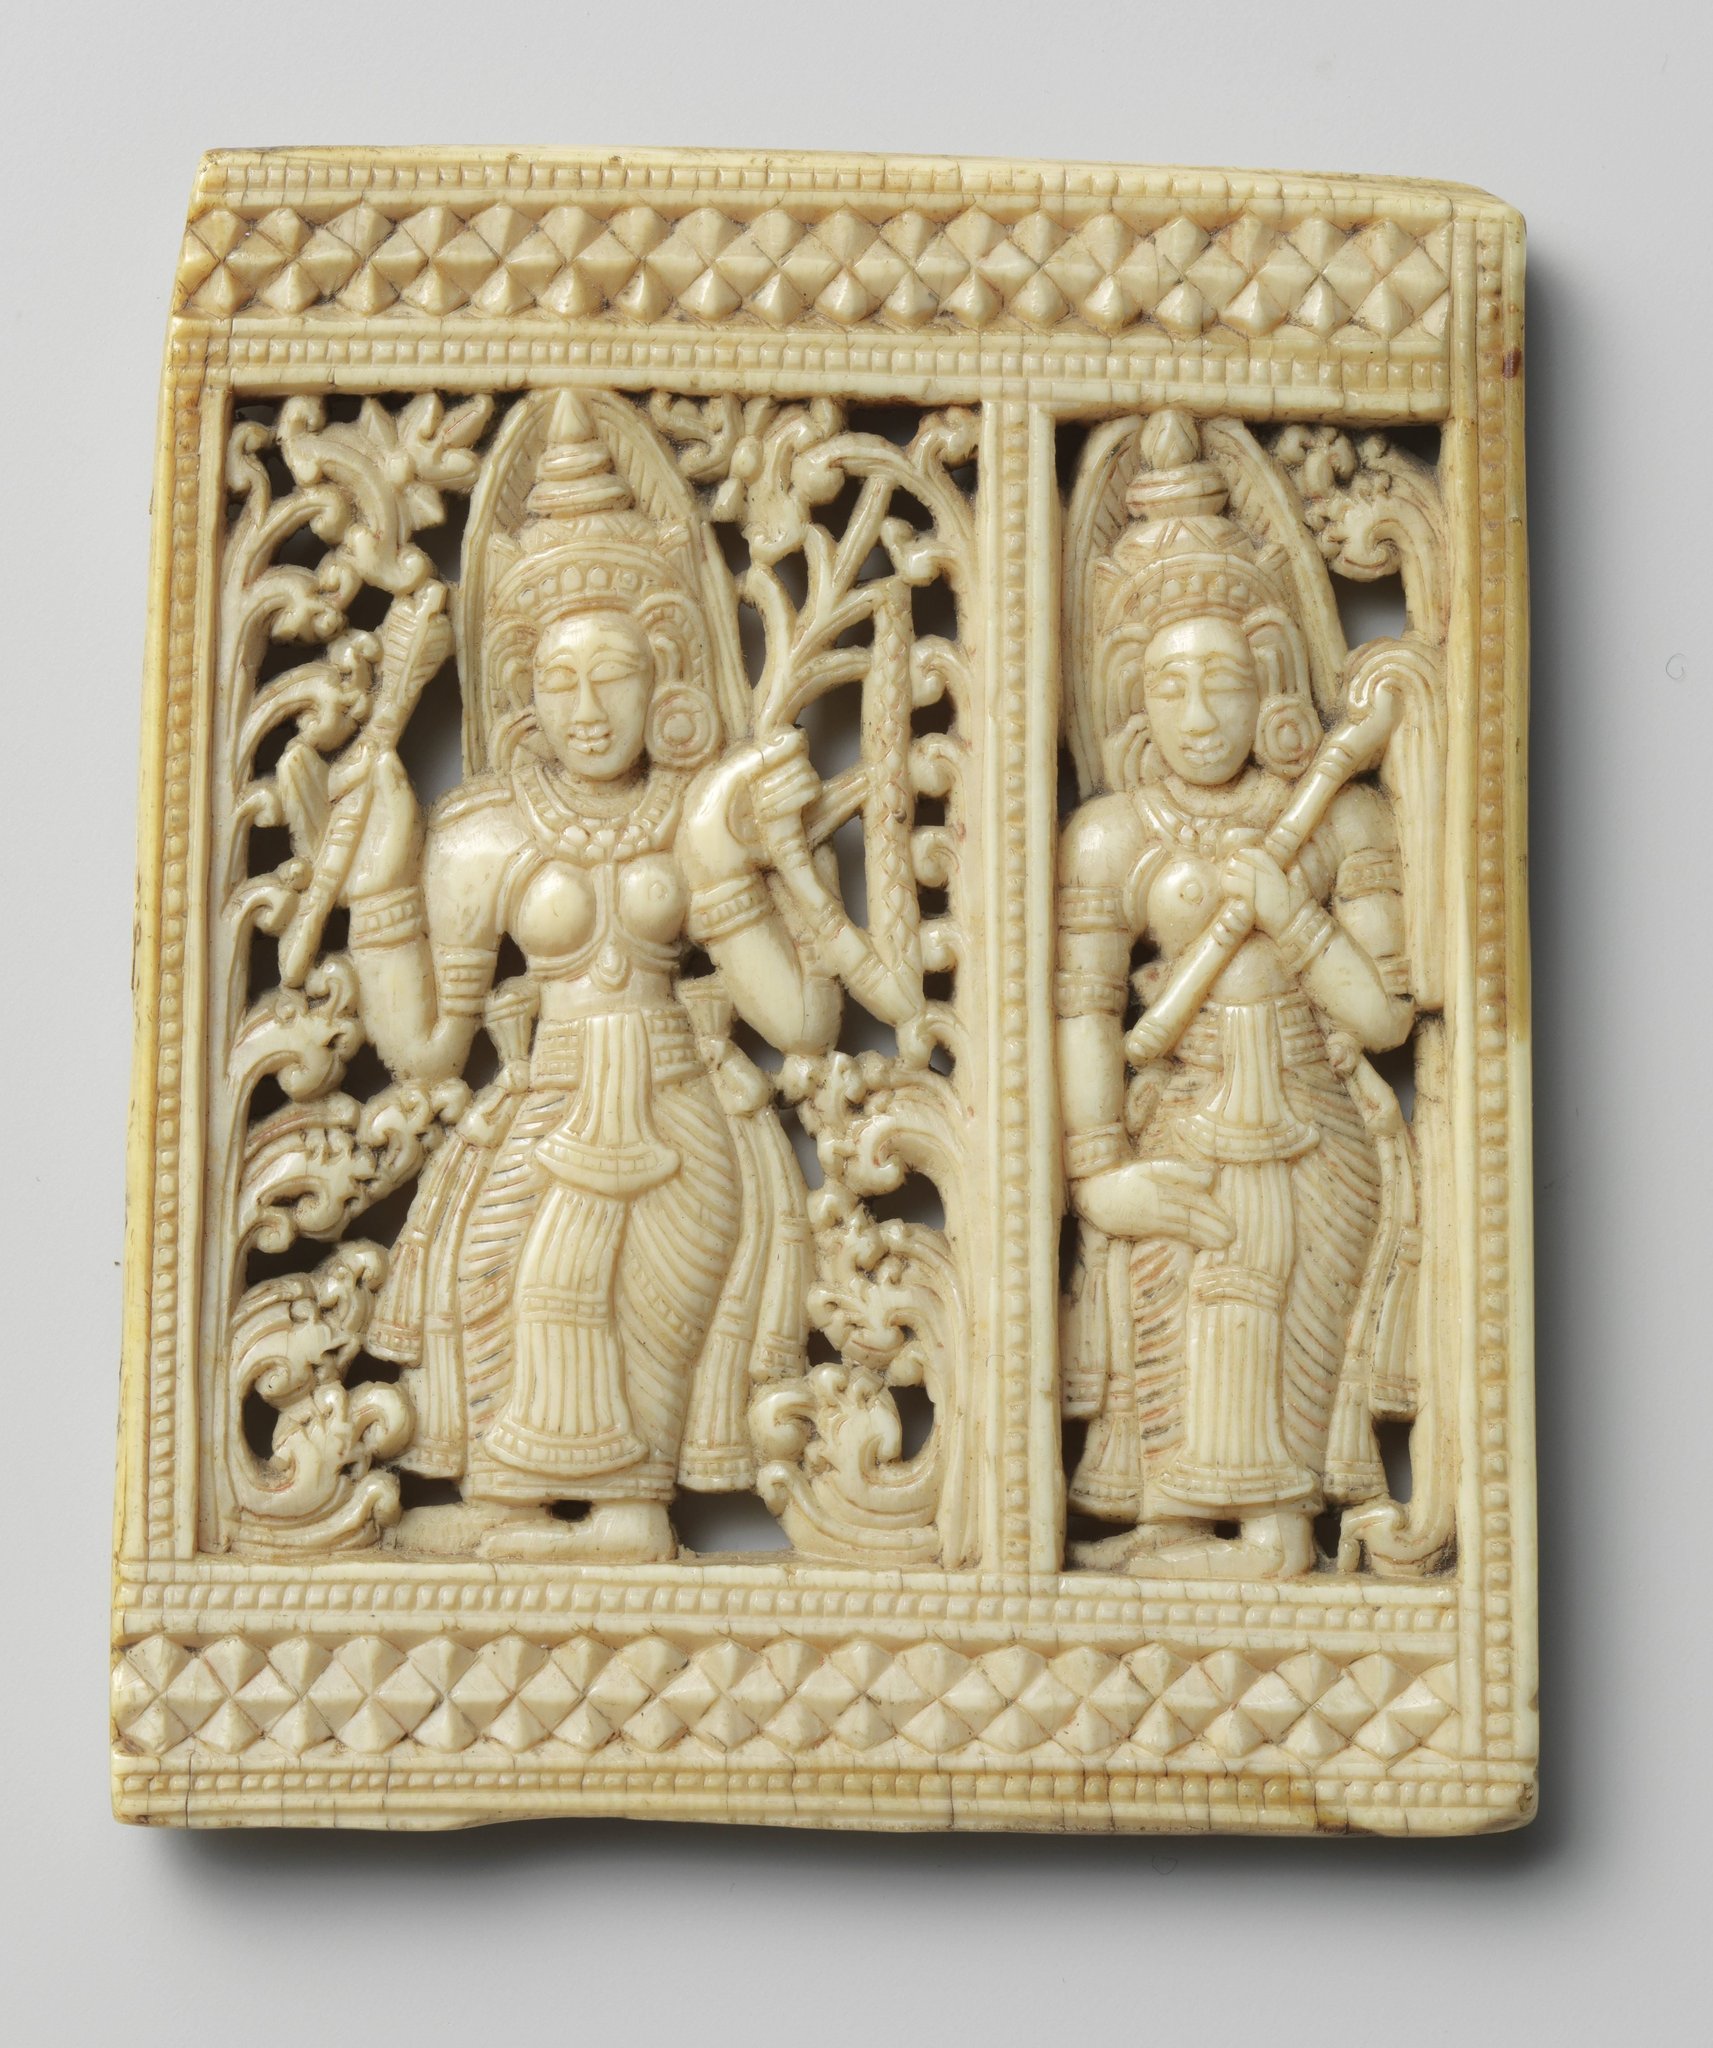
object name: fragment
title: Fragment van een haarkam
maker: Anonymous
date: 1700-1800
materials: ivory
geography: sri lanka